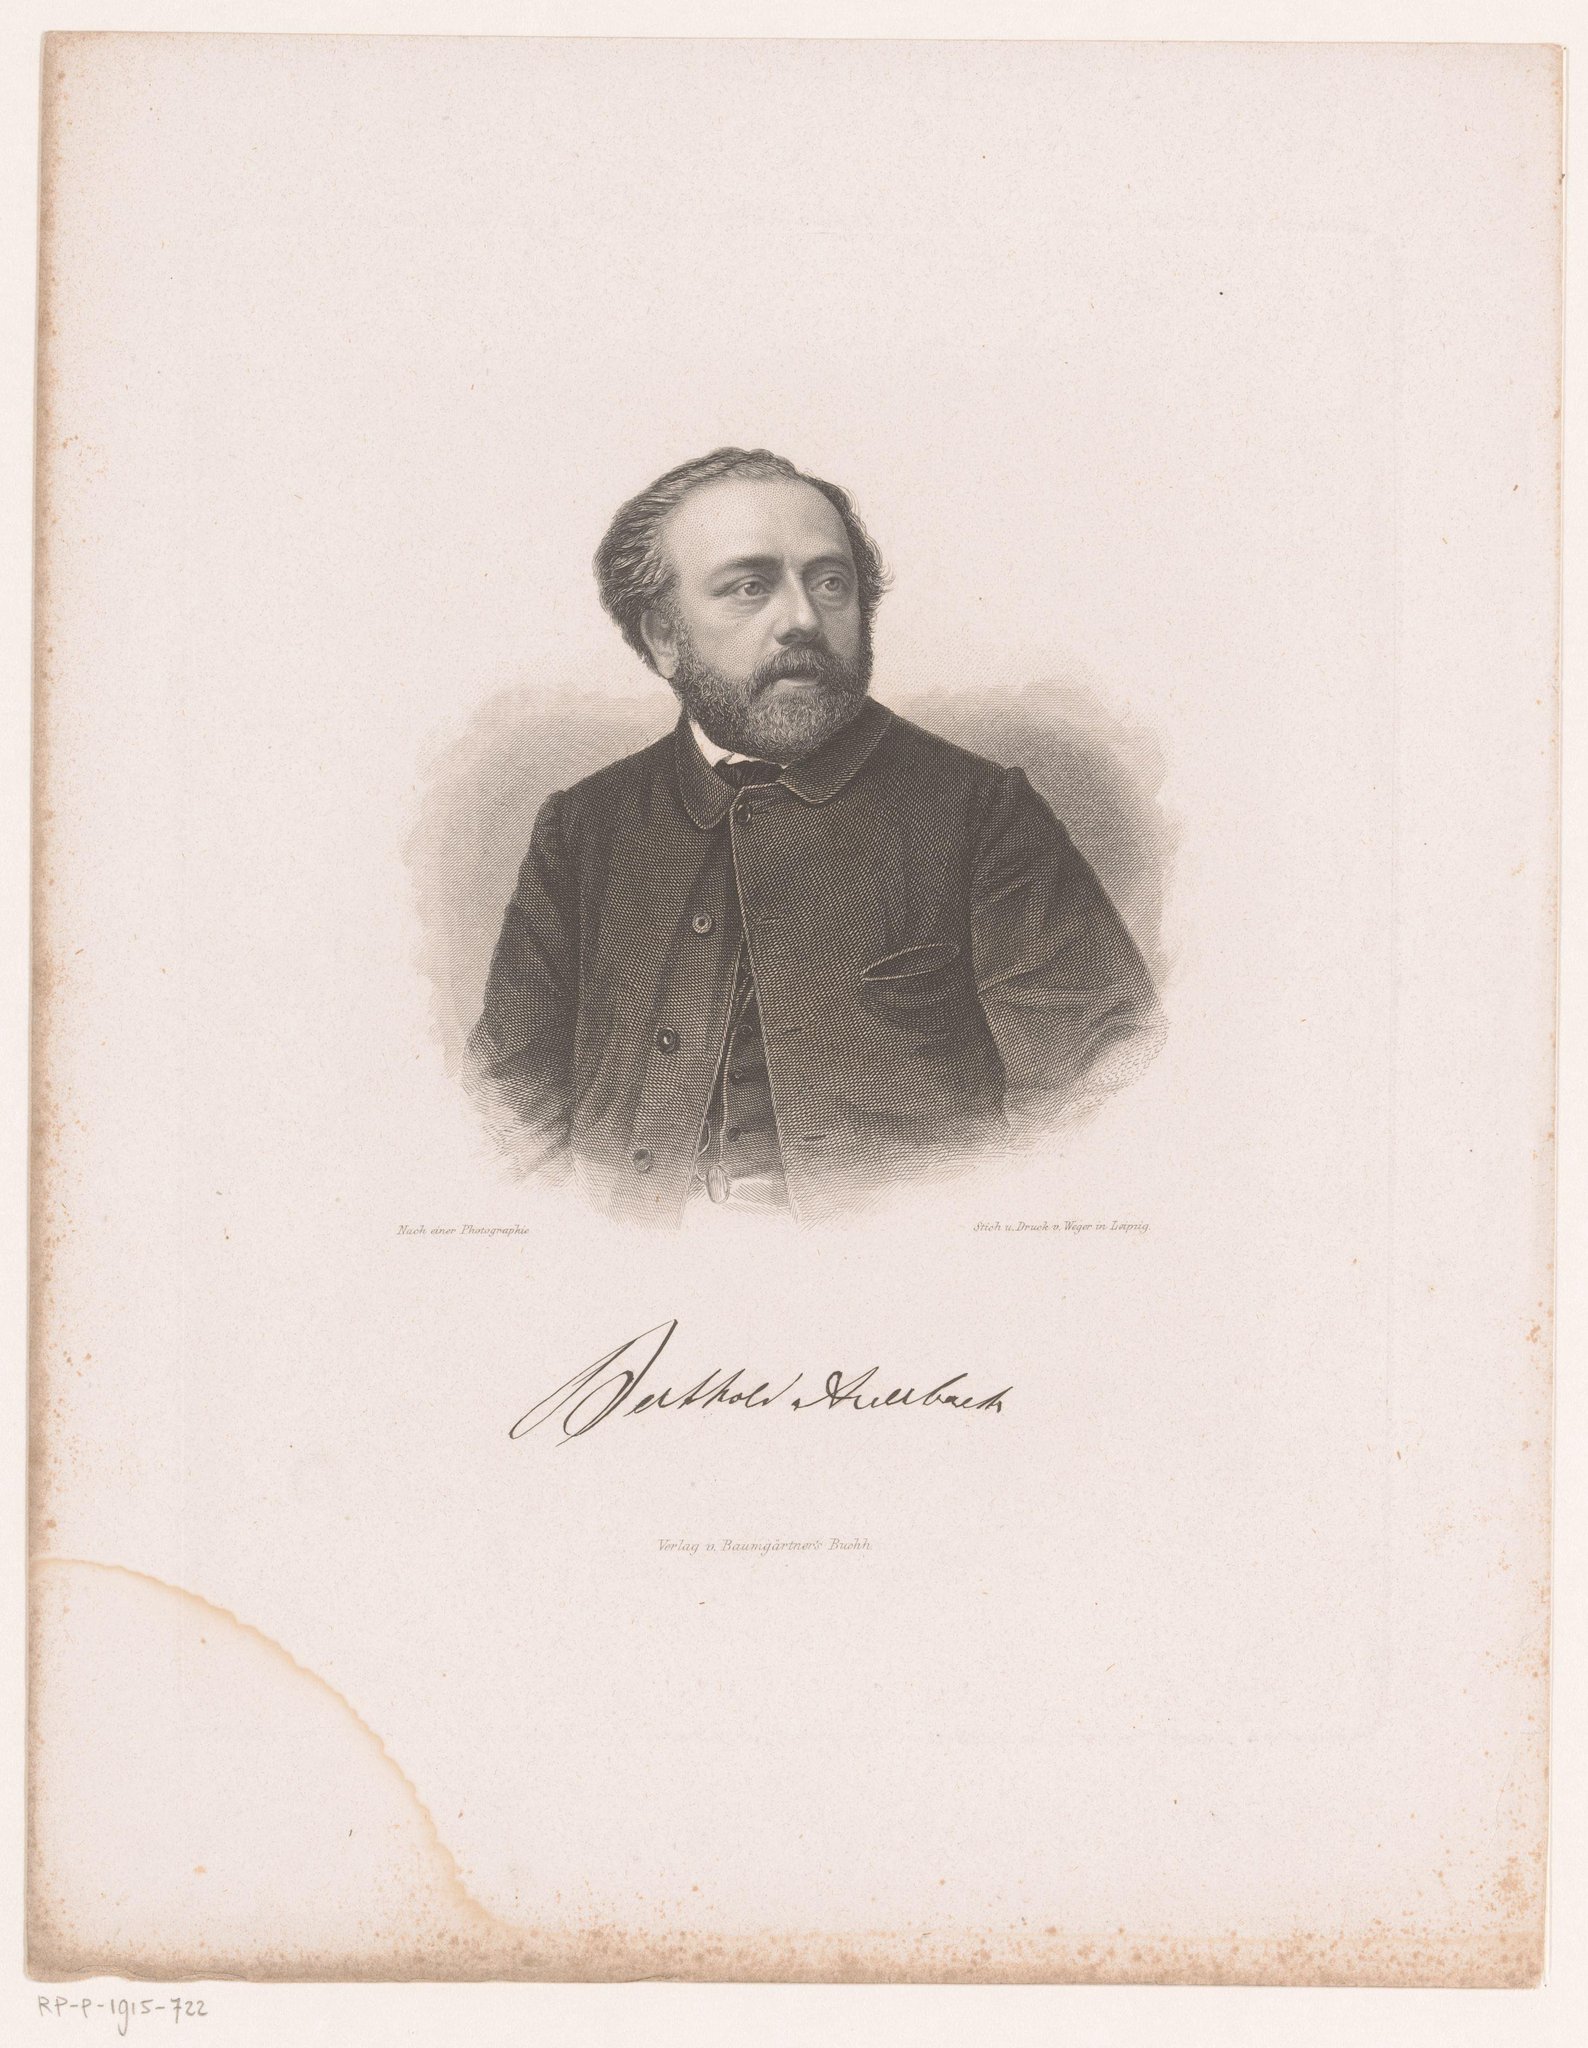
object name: print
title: Portret van Berthold Auerbach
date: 1849-1892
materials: paper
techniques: engraving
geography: leipzig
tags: historical persons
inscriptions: collector's mark: Lugt 2228